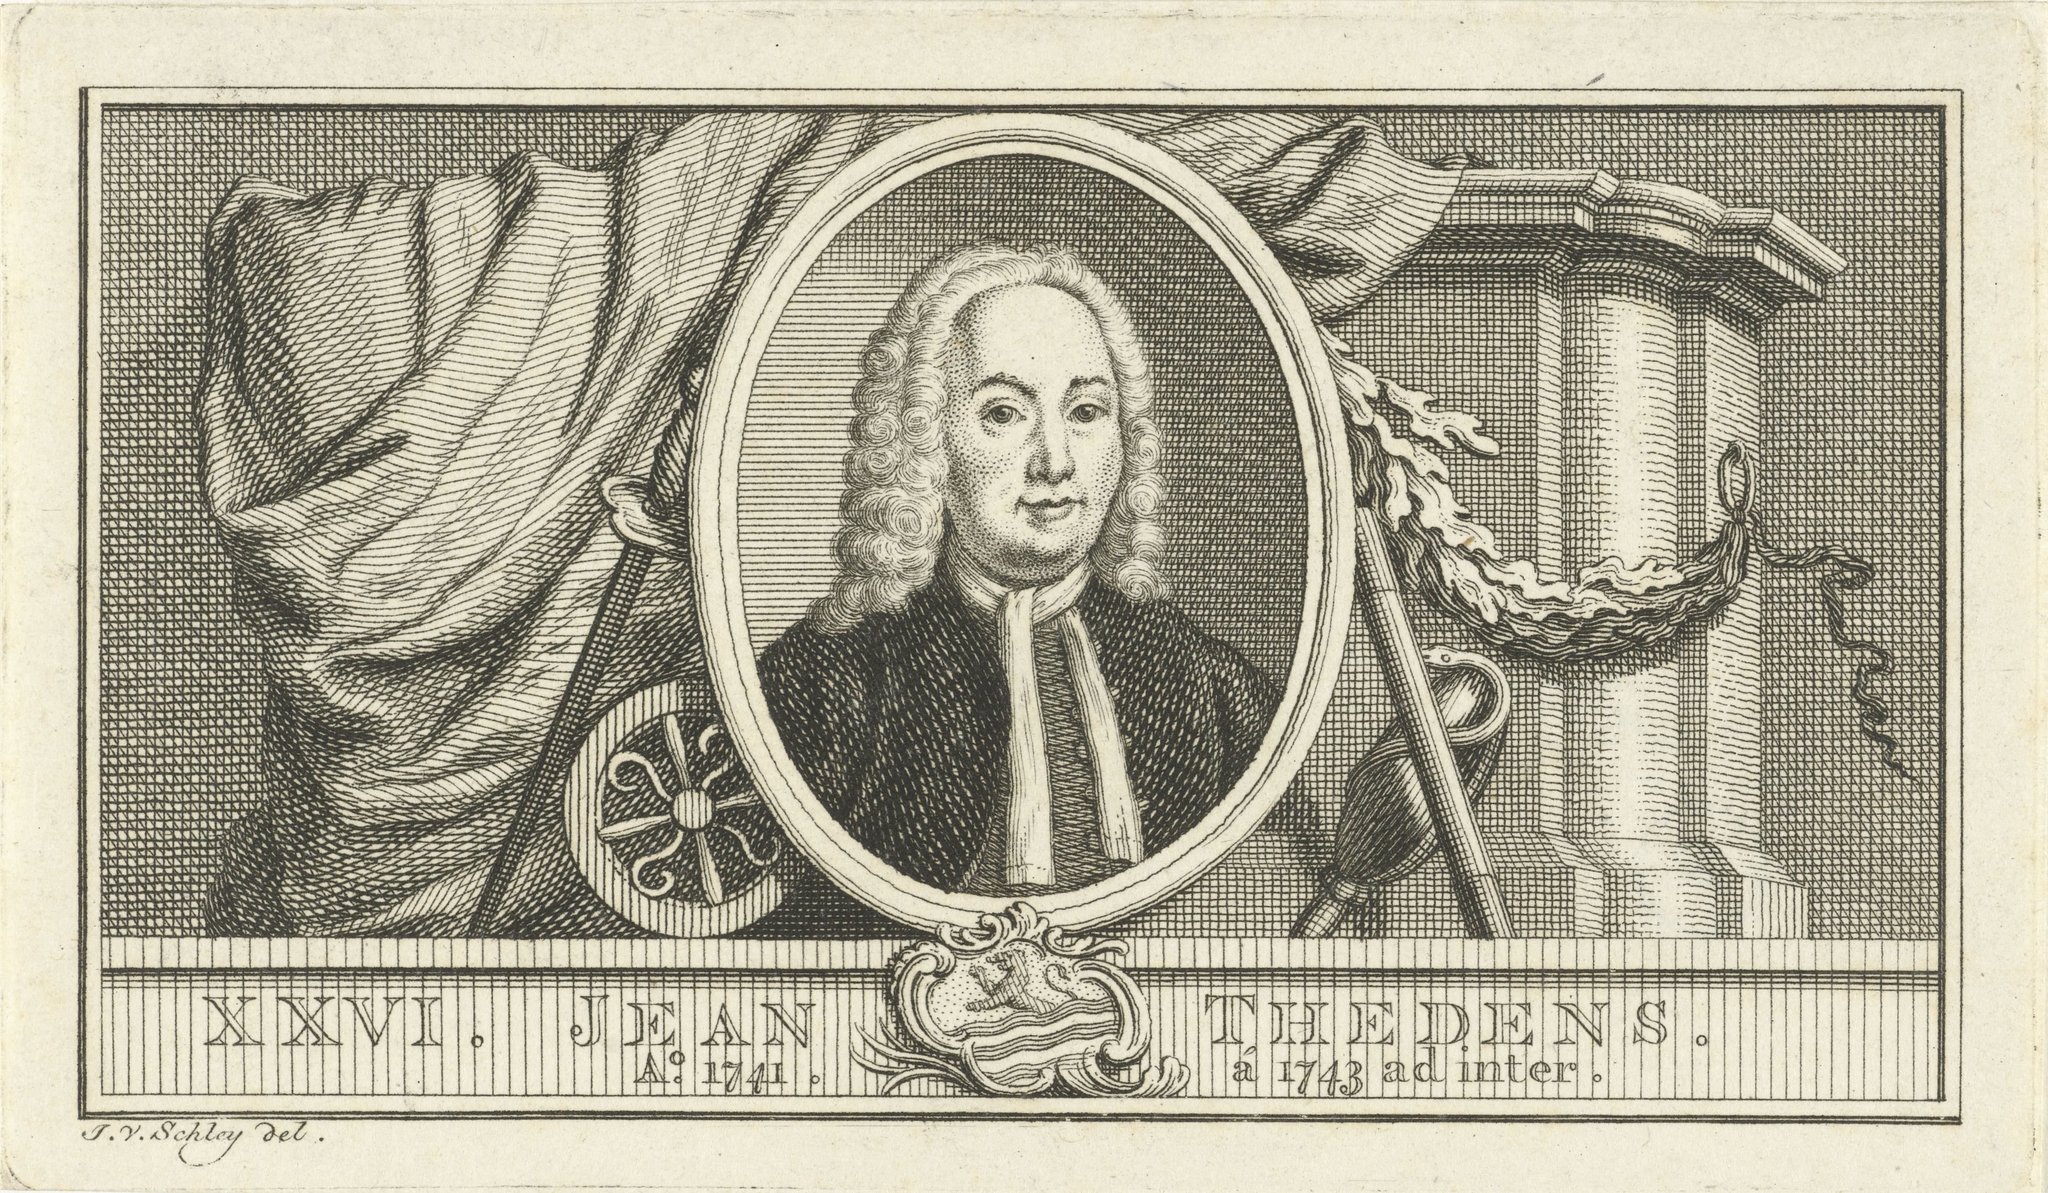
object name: print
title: Portret van Johannes Thedens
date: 1763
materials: paper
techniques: engraving, etching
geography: the hague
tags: germany, batavia, column, pillar ~ architecture, baton of general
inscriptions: collector's mark: Lugt 964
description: Ook gebruikt als illustratie in: Du Bois, J.P.I. Vies des gouverneurs généraux avec l'abrégé de l'histoire des établissemens hollandais aux Indes Orientales. Den Haag: Pierre de Hondt, 1763, p. 333.